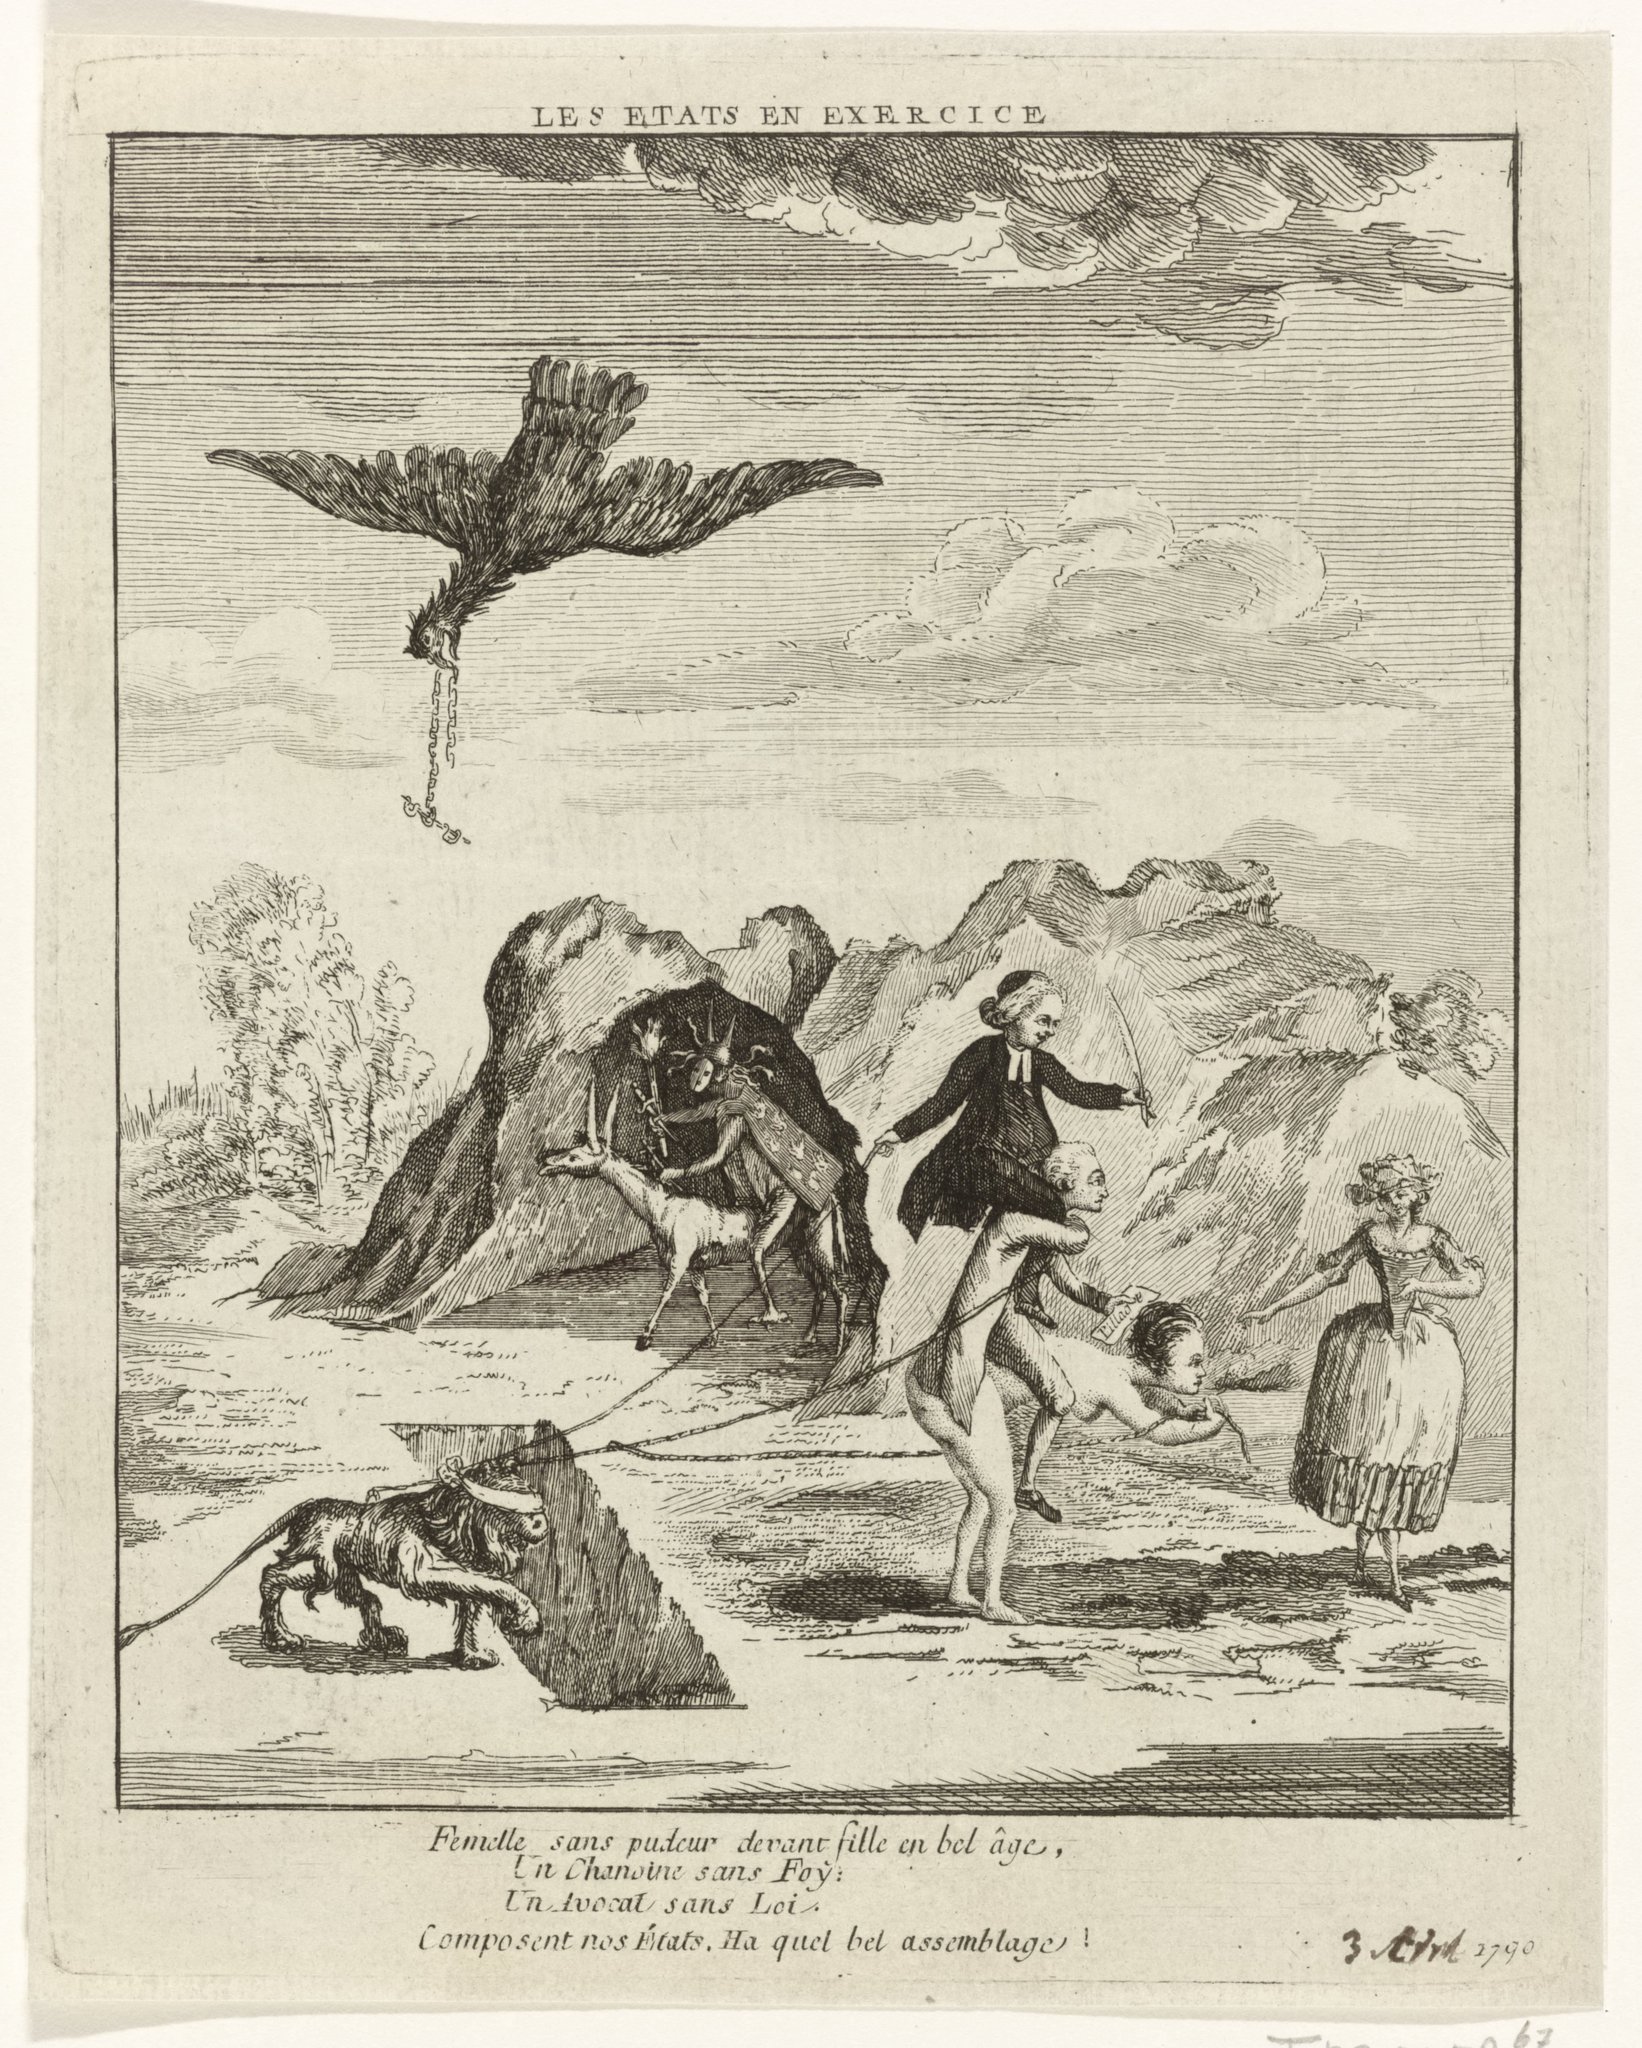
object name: cartoon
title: Spotprent op Hendrik van der Noot en Petrus van Eupen, 1790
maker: Anonymous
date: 1704-1790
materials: paper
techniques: engraving, etching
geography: southern netherlands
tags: brussels, politician, antwerp, priest, brabant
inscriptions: collector's mark: Lugt 2228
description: Spotprent waarin Hendrik van der Noot en Petrus van Eupen zitten op de rug van een naakte vrouw. Zij zijn met kettingen verbonden aan de geblinddoekte Brabantse leeuw en worden door een jonge vrouw (Madame Pinau?) gelokt waardoor de blinde leeuw in een kuil dreigt te stappen. In de lucht de Oostenrijkse adelaar met boeien in de bek. Op de achtergrond een duivel op een ezel in een grot. Met vierreglig Frans onderschrift. Hierbij de datum 3 april 1790 met de hand geschreven. Onderdeel van een grote groep van prenten betrekking hebbend op de gebeurtenissen van de Brabantse Omwenteling en de periode 1787-1790.